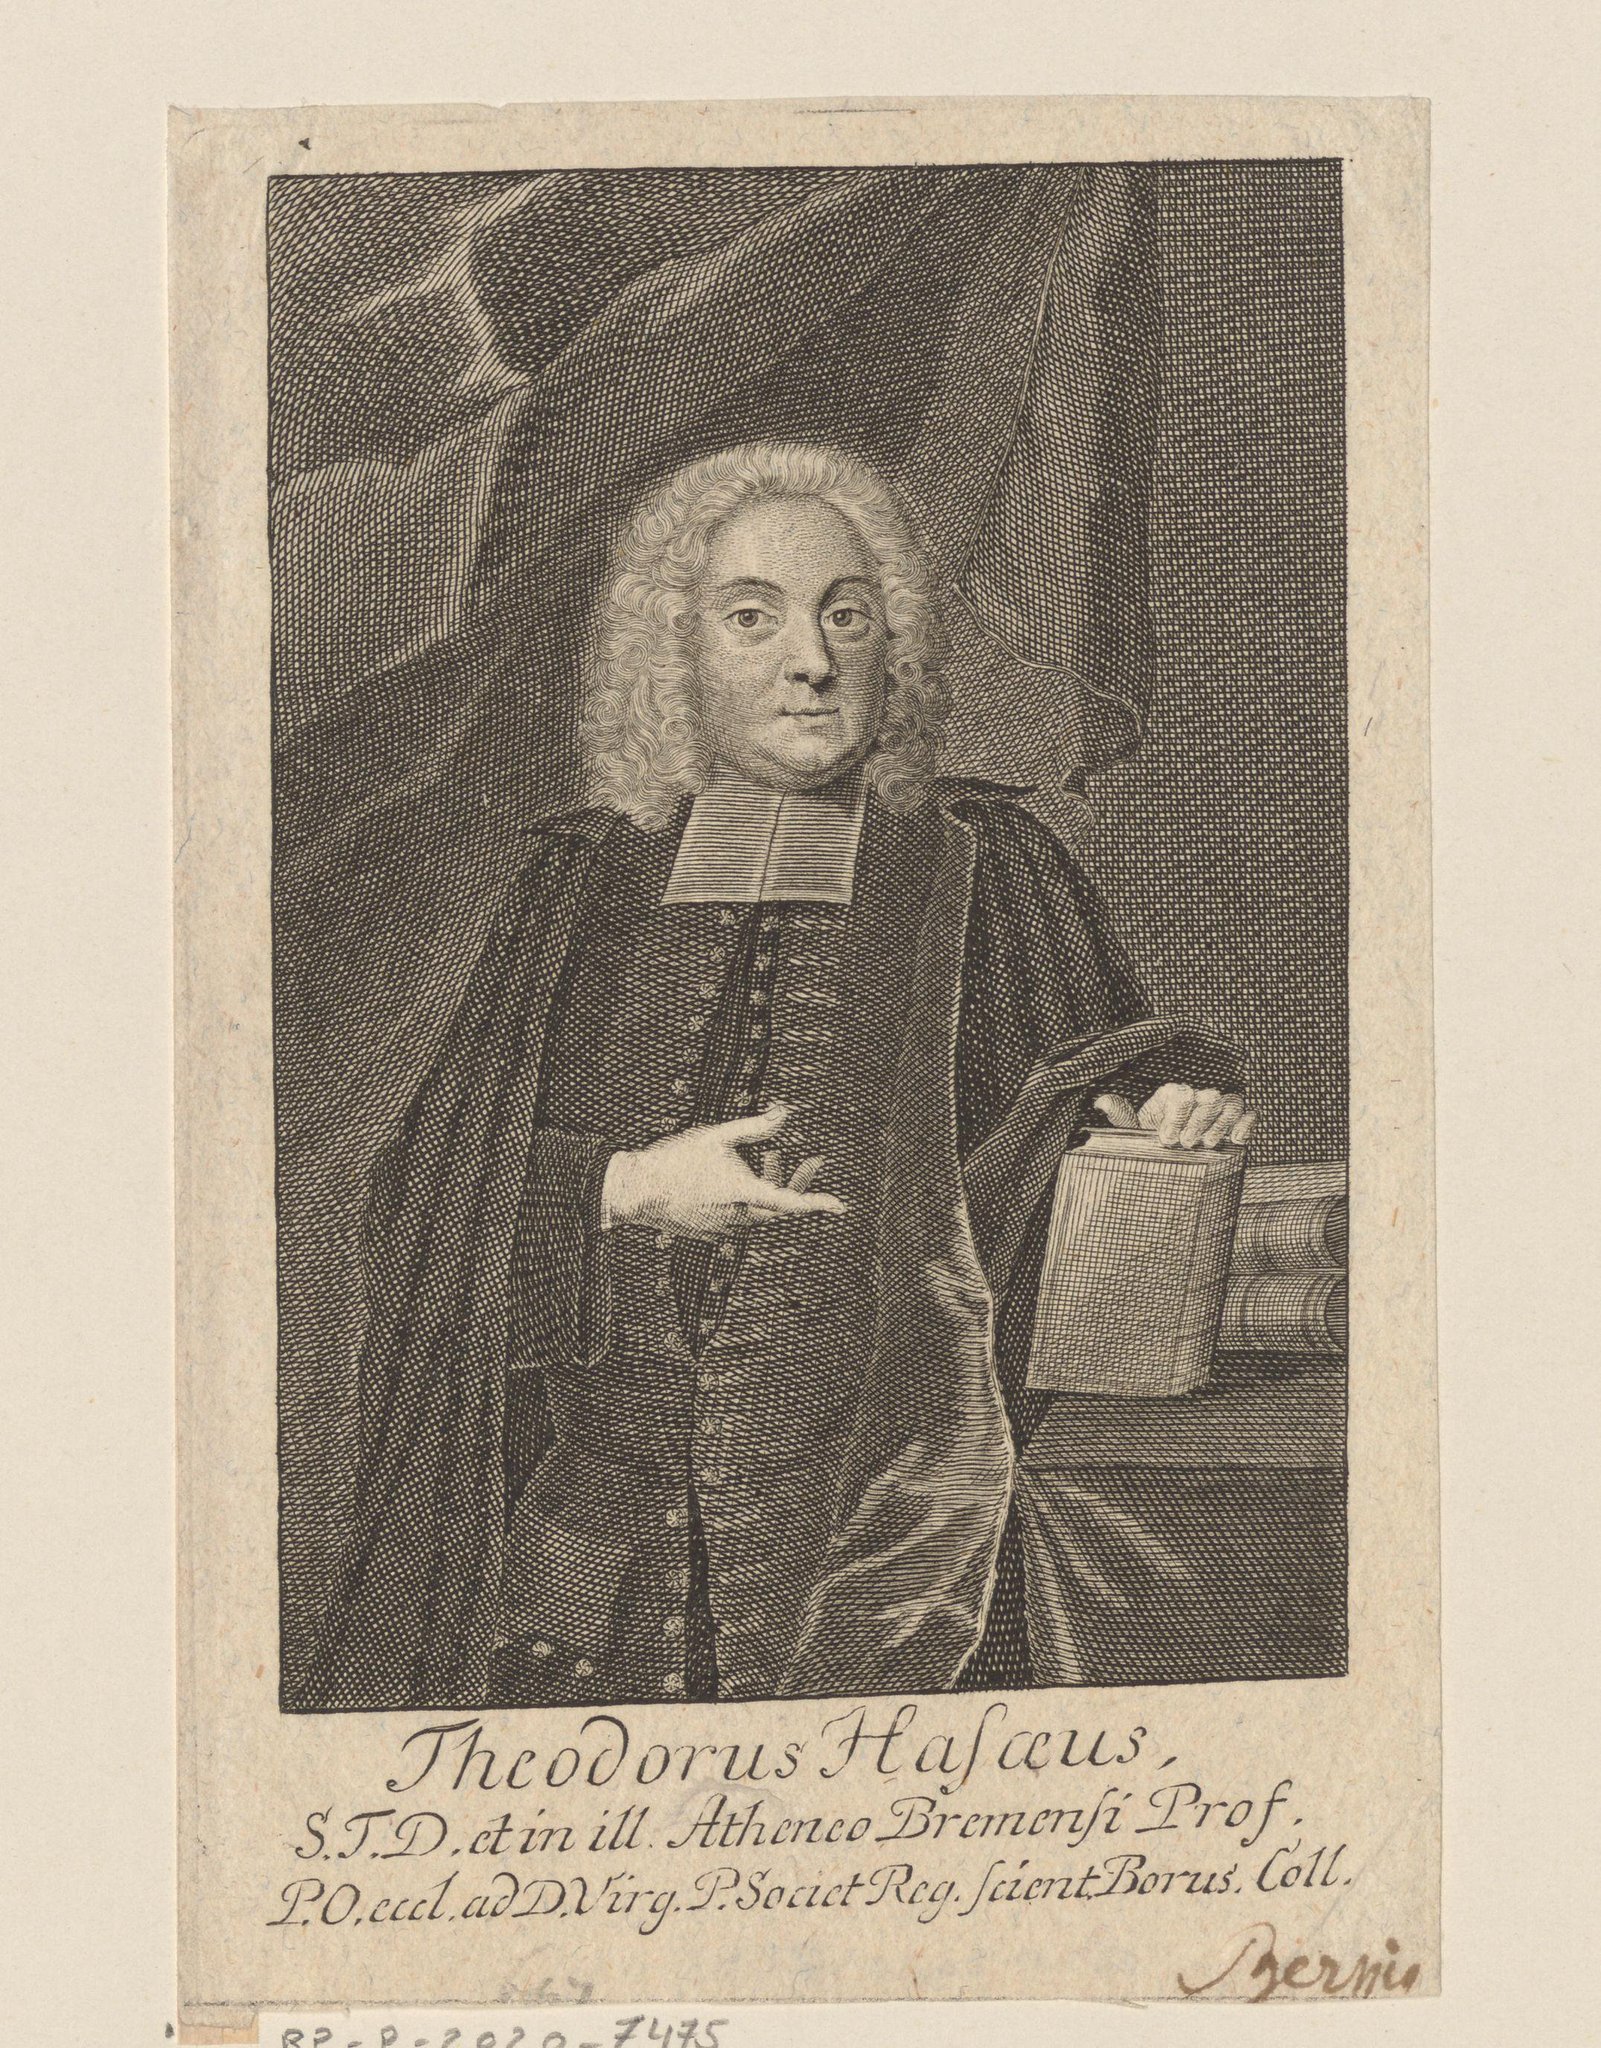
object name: print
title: Portret van Theodor Hase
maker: martin bernigeroth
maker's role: print maker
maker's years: 1670-1733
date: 1708-1733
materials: paper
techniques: engraving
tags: theologian, historical persons, book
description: Prent mogelijk uit: Deutsche Acta Eruditorum (...). Leipzig: Johann Gottlieb Gleditsch, 1729, dl. 145.